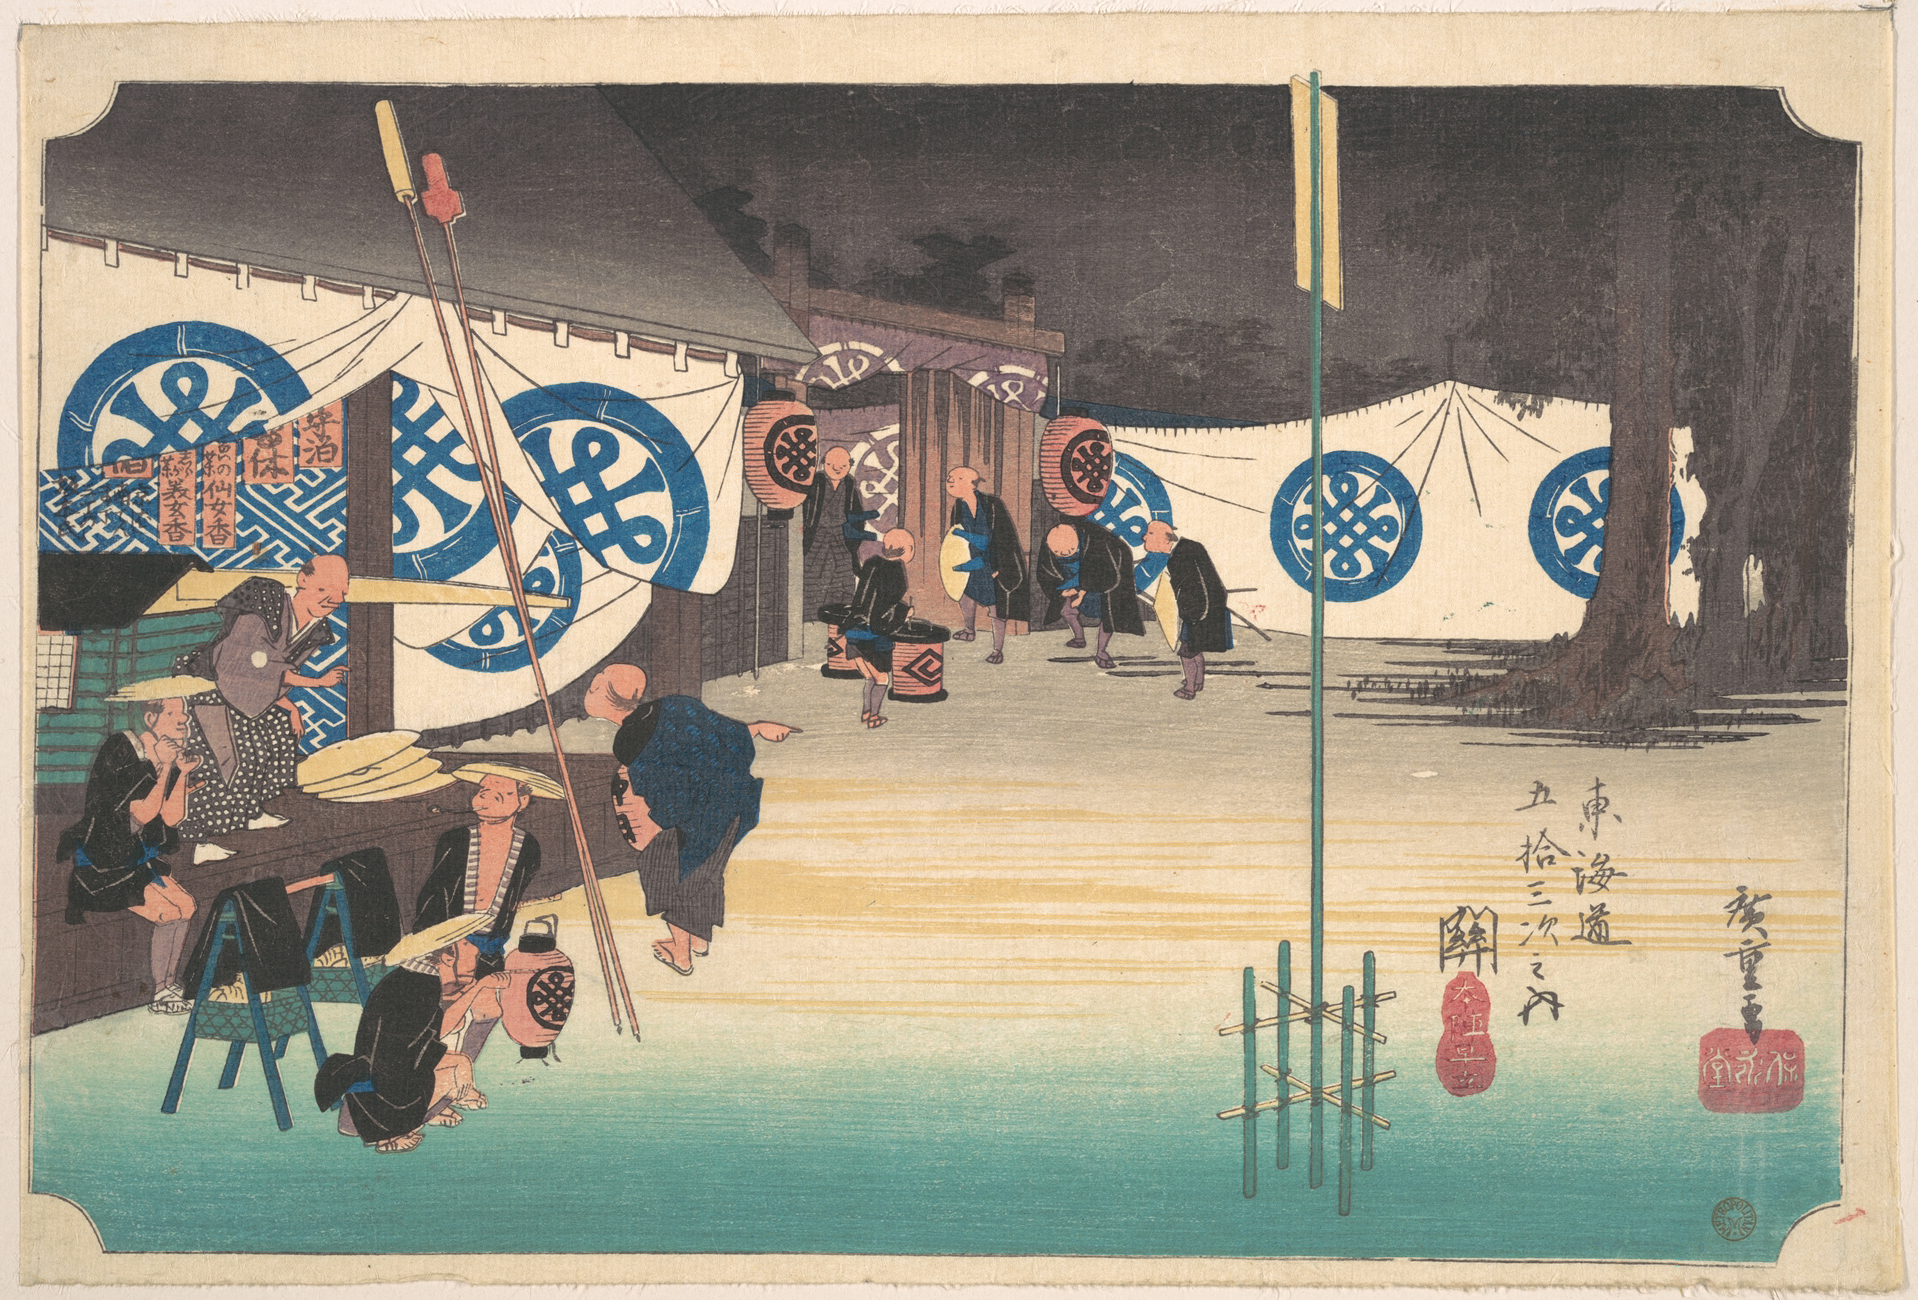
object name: print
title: Seki, Honjin Sotatsu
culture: japanese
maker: utagawa hiroshige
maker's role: artist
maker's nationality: japanese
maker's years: 1797-1858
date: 1834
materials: ink, paper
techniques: woodblock print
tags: men